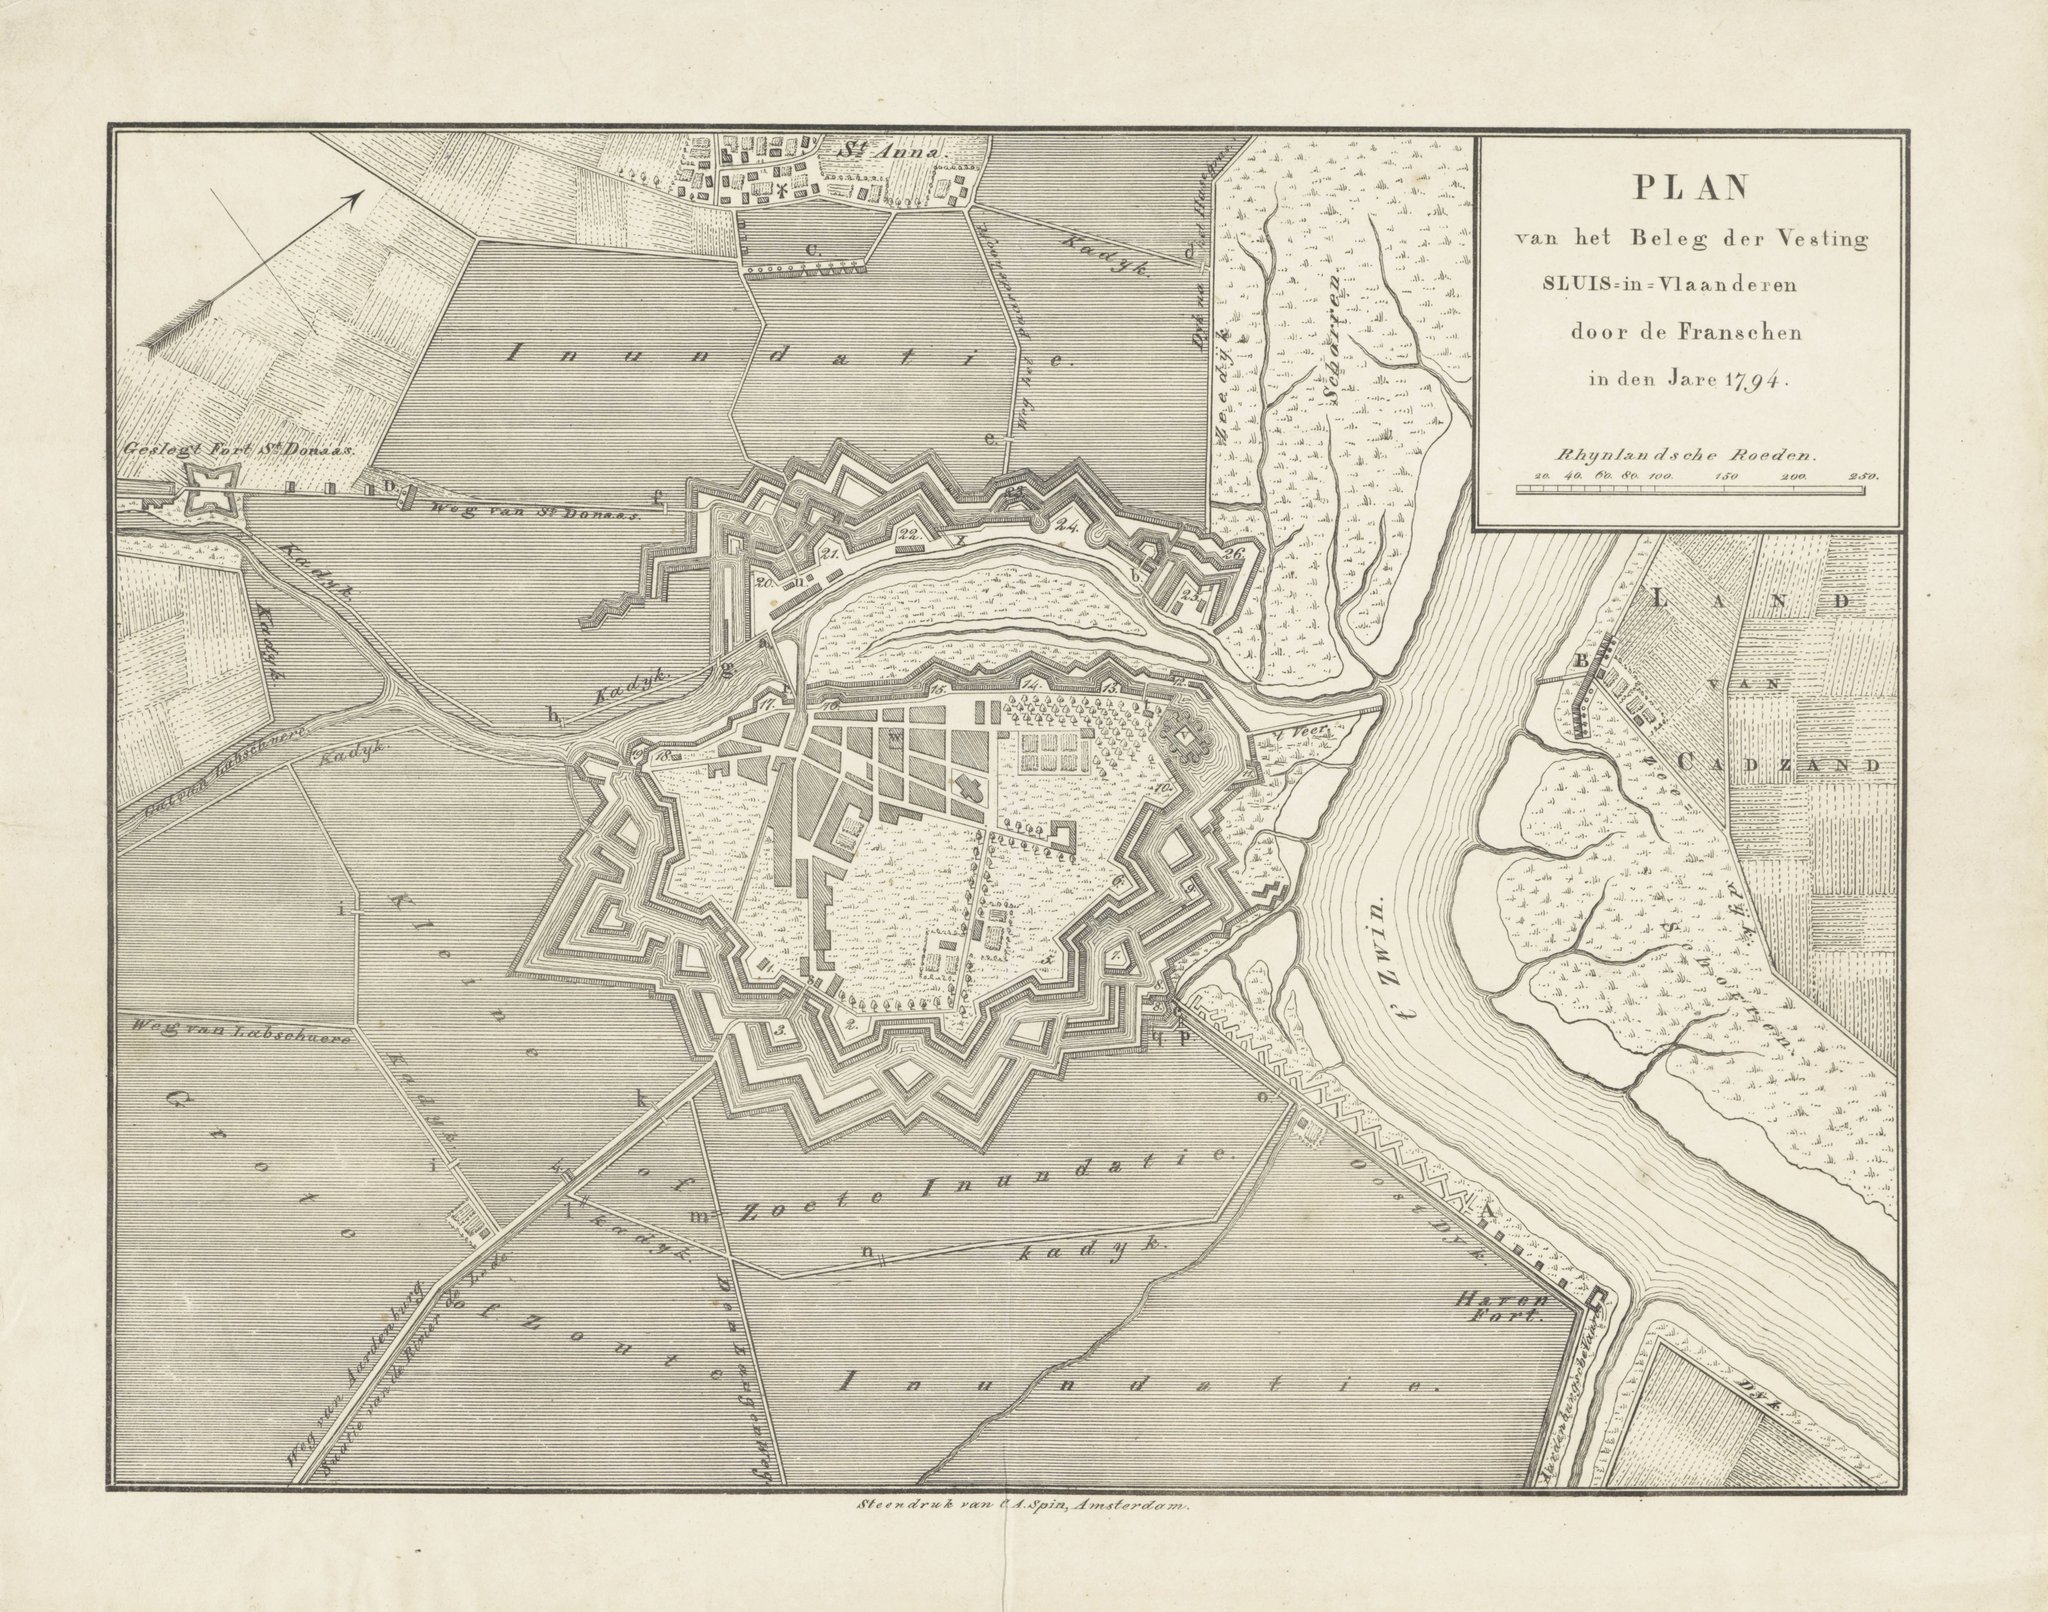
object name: print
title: Beleg van Sluis, 1794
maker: christiaan andersen spin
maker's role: printer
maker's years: 1792-1865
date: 1834-1856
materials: paper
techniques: lithograph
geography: amsterdam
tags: fortified city, maps of cities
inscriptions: collector's mark: Lugt 2228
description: Gebruikt als illustratie in: Johannes Bosscha, Neêrlands heldendaden te land, van de vroegste tijden af tot in onze dagen. 3 dl. in 4 bd, Leeuwarden : Suringar, 1834-1856.